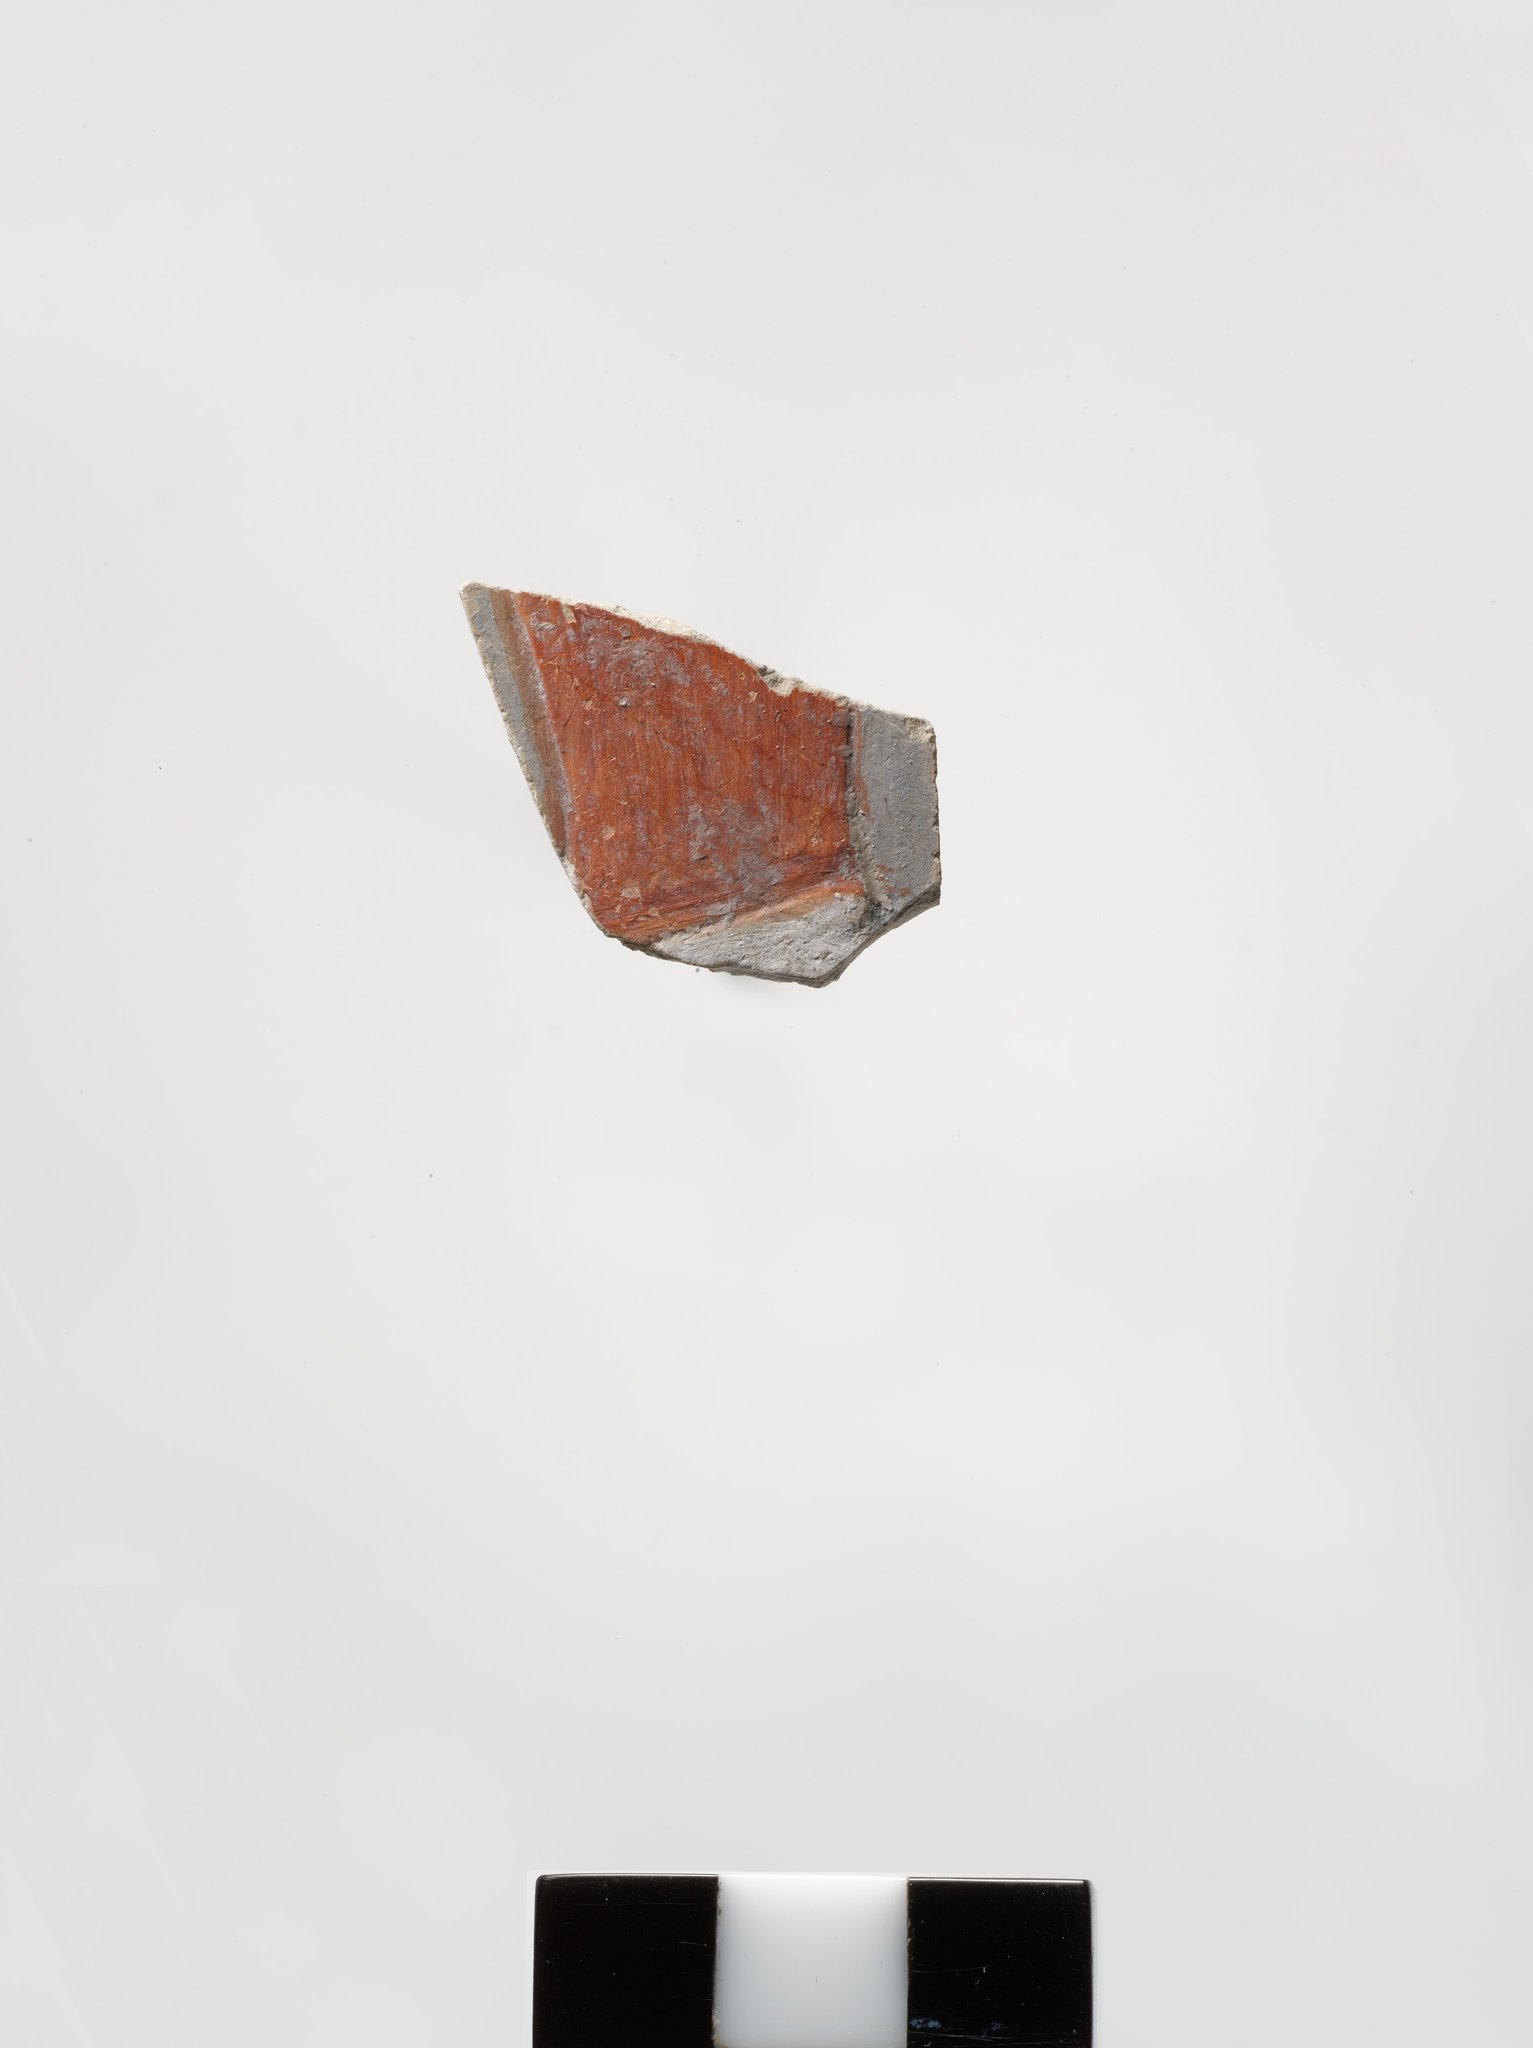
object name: relief fragment, tomb of meketre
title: Relief fragment from the tomb of Meketre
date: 1981-1975 BCE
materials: limestone, paint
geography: egypt